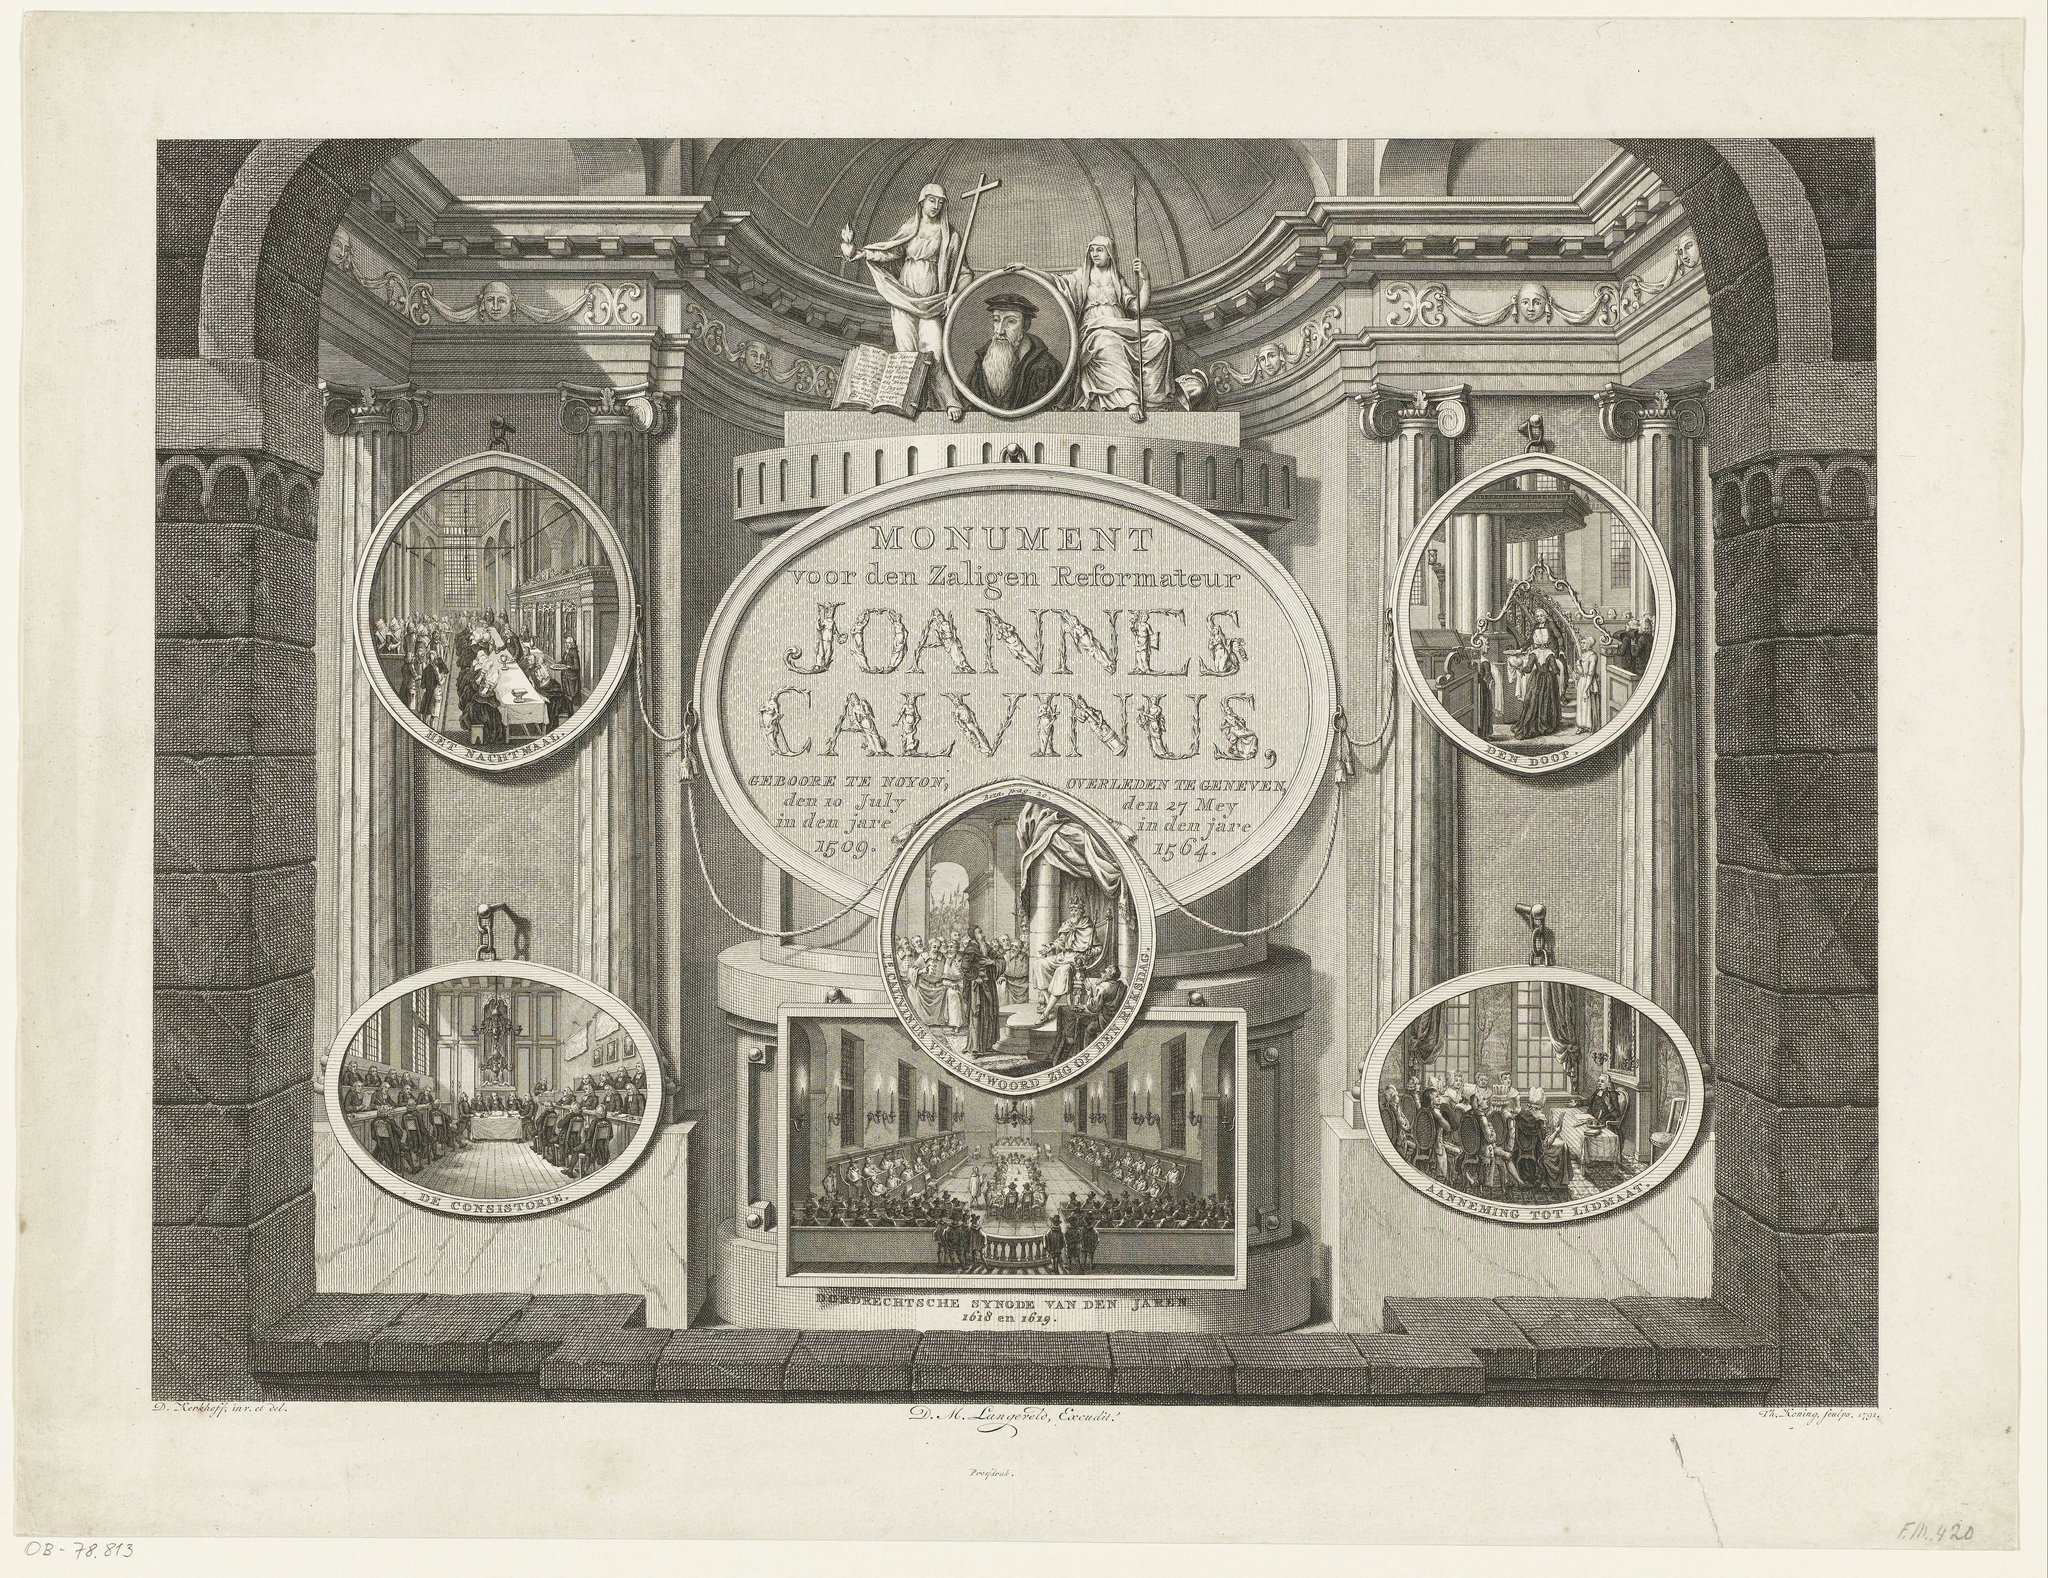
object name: print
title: Monument voor den Zaligen Reformateur Joannes Calvinus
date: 1791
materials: paper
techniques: etching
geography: netherlands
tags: reformation (roman catholic church vs. protestantism), divine service ~ christian churches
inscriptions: date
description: Monument voor Johannes Calvijn, 1509-1564. Boven een klein portret van de kerkhervormer, links en rechts scènes van plechtigheden in de calvinistische kerk rond het jaar 1791: avondmaal, consistorie, doop en de aanneming tot lidmaat. In het midden Calvijn op de Rijksdag en een afbeelding van de Dordtse synode van 1618-1619. Proefdruk. Zinneprent op de Hervorming.